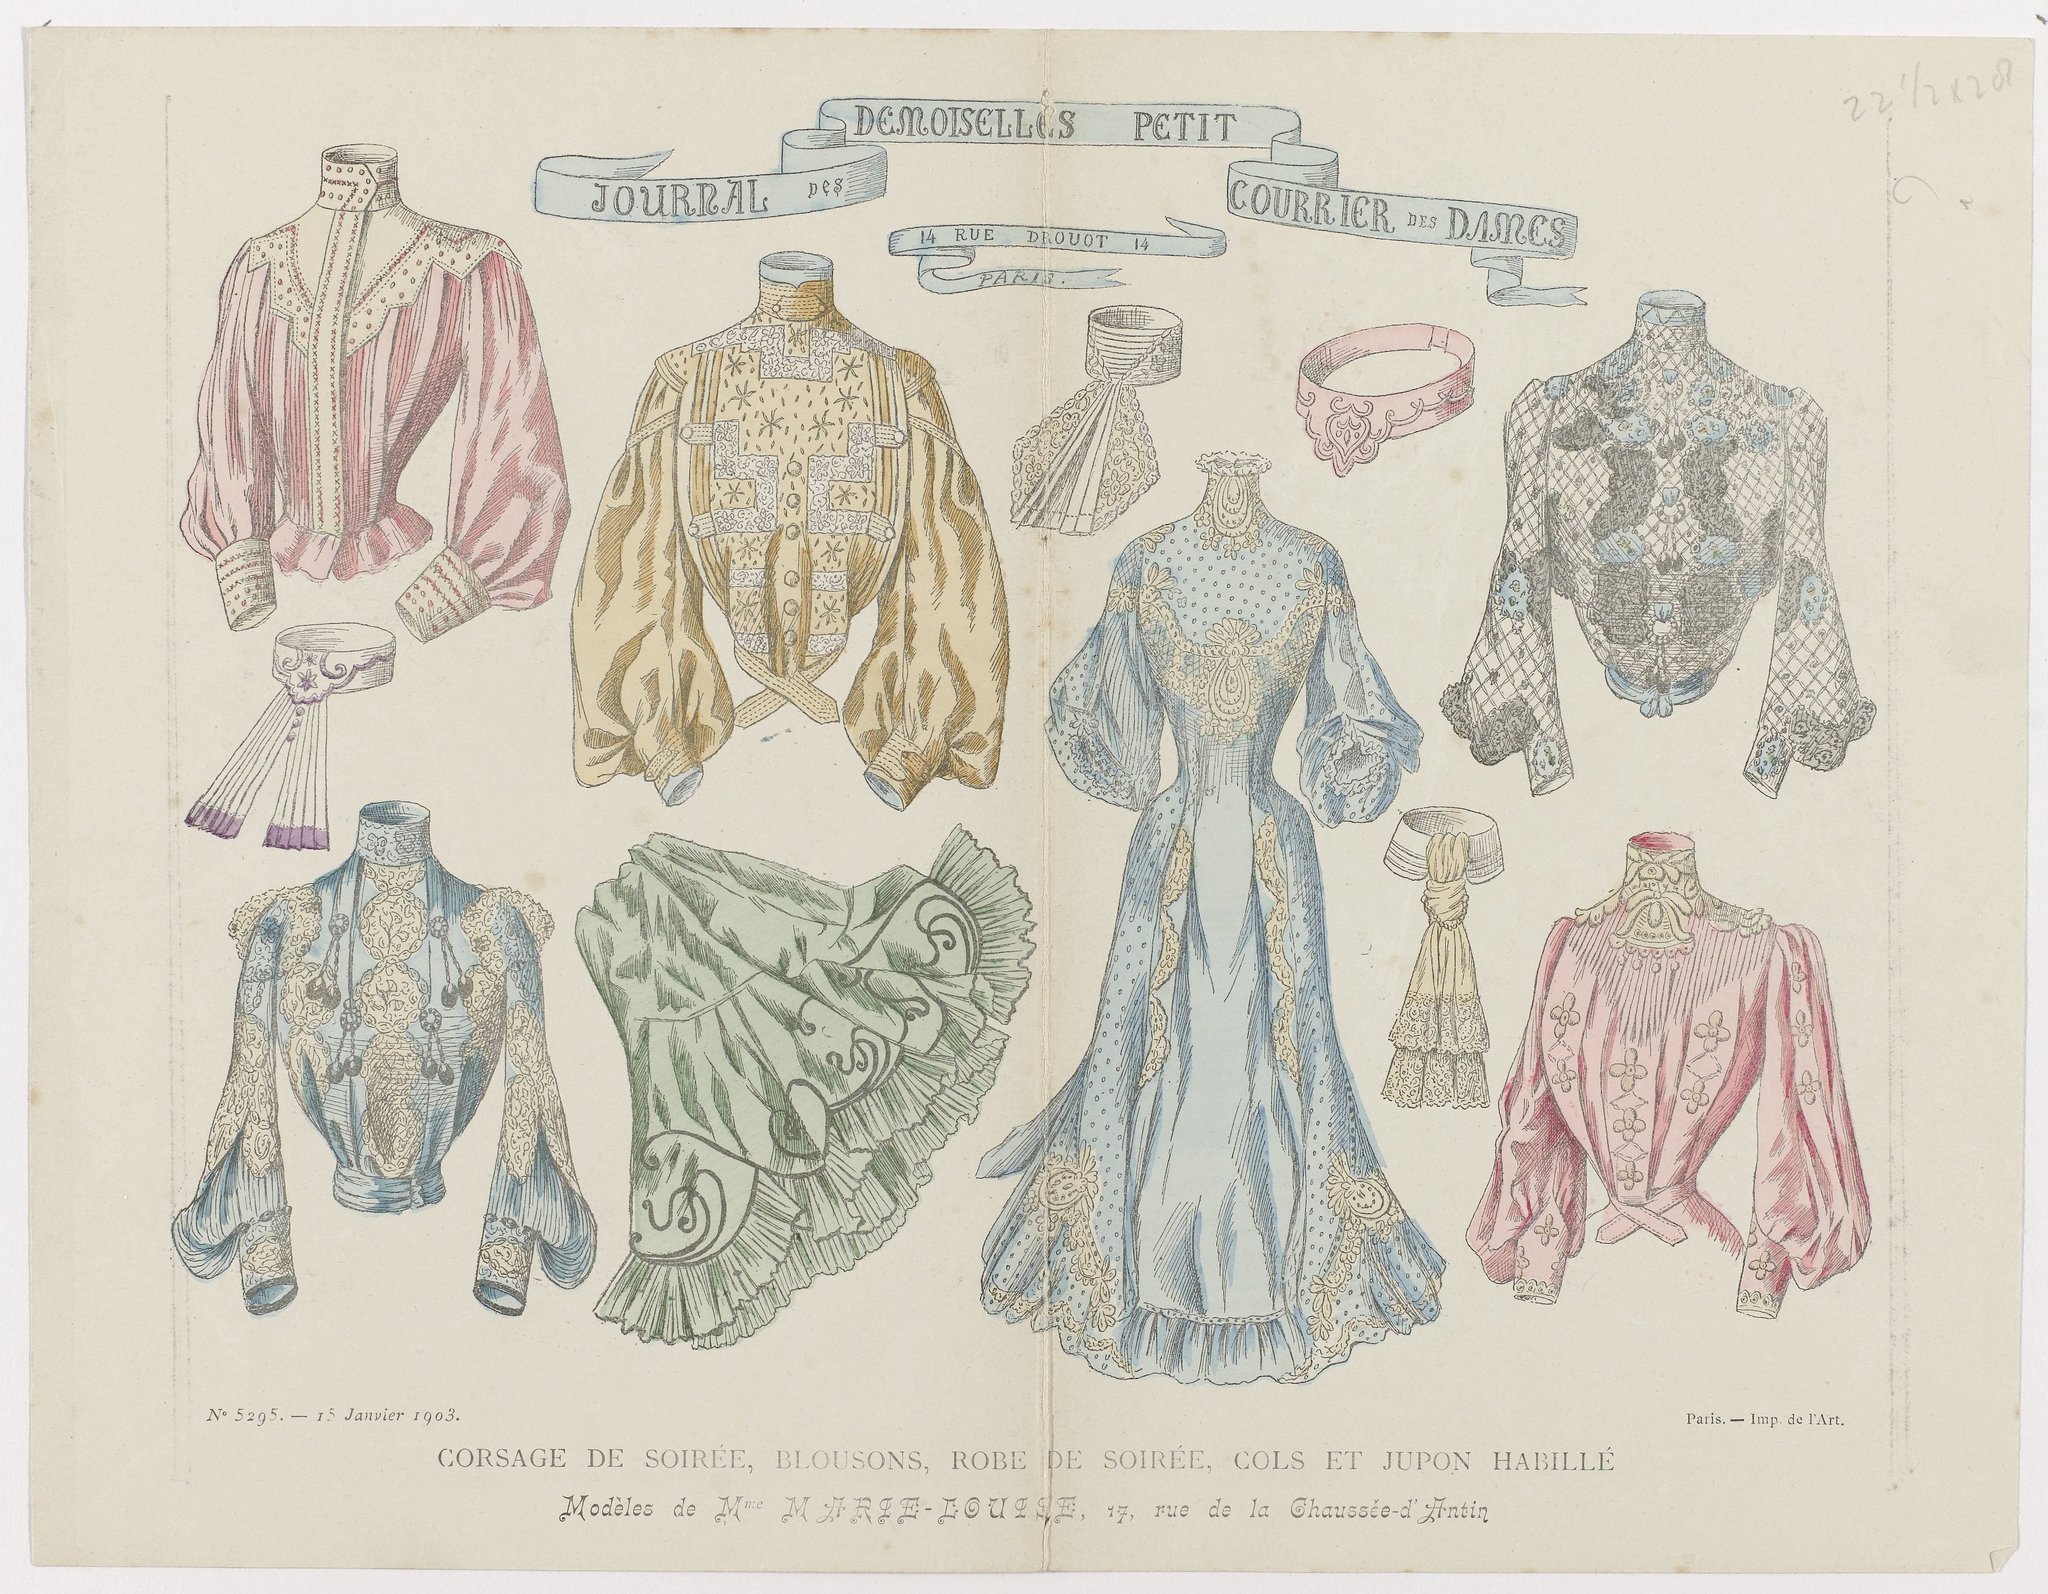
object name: fashion print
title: Journal des Demoiselles et Petit Courrier des Dames, 1 Janvier 1903, No. 5295 : Corsage de soiré (...)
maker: Anonymous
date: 1903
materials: paper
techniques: etching, hand coloring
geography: paris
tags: clothing for the upper part of the body (+ women's clothes), dress, gown: evening dress (+ women's clothes), clothing for the upper part of the body: blouse (+ women's clothes), underclothes for the lower part of the body (underskirt) (+ women's clothes), neck-gear: collar (+ women's clothes), fashion plates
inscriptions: title: ‘JOURNAL DES DEMOISELLES PETIT COURRIER DES DAMES’, address: ‘14 RUE DROUOT 14 / PARIS’, caption: ‘CORSAGE DE SOIRÉE, BLOUSONS, ROBE DE SOIRÉE, COLS ET JUPON HABILLÉ / Modèles de Mme MARIE-LOUISE, 17, rue de la Chaussée- d'Antin’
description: Lijfje voor de avond, blouses, avondjapon, kragen en een onderrok of 'jupon habillé'. Volgens het onderschrift: 'modèles' van Marie-Louise. Prent uit het modetijdschrift Journal des Demoiselles (et Petit Courrier des Dames) (1833 -1922).